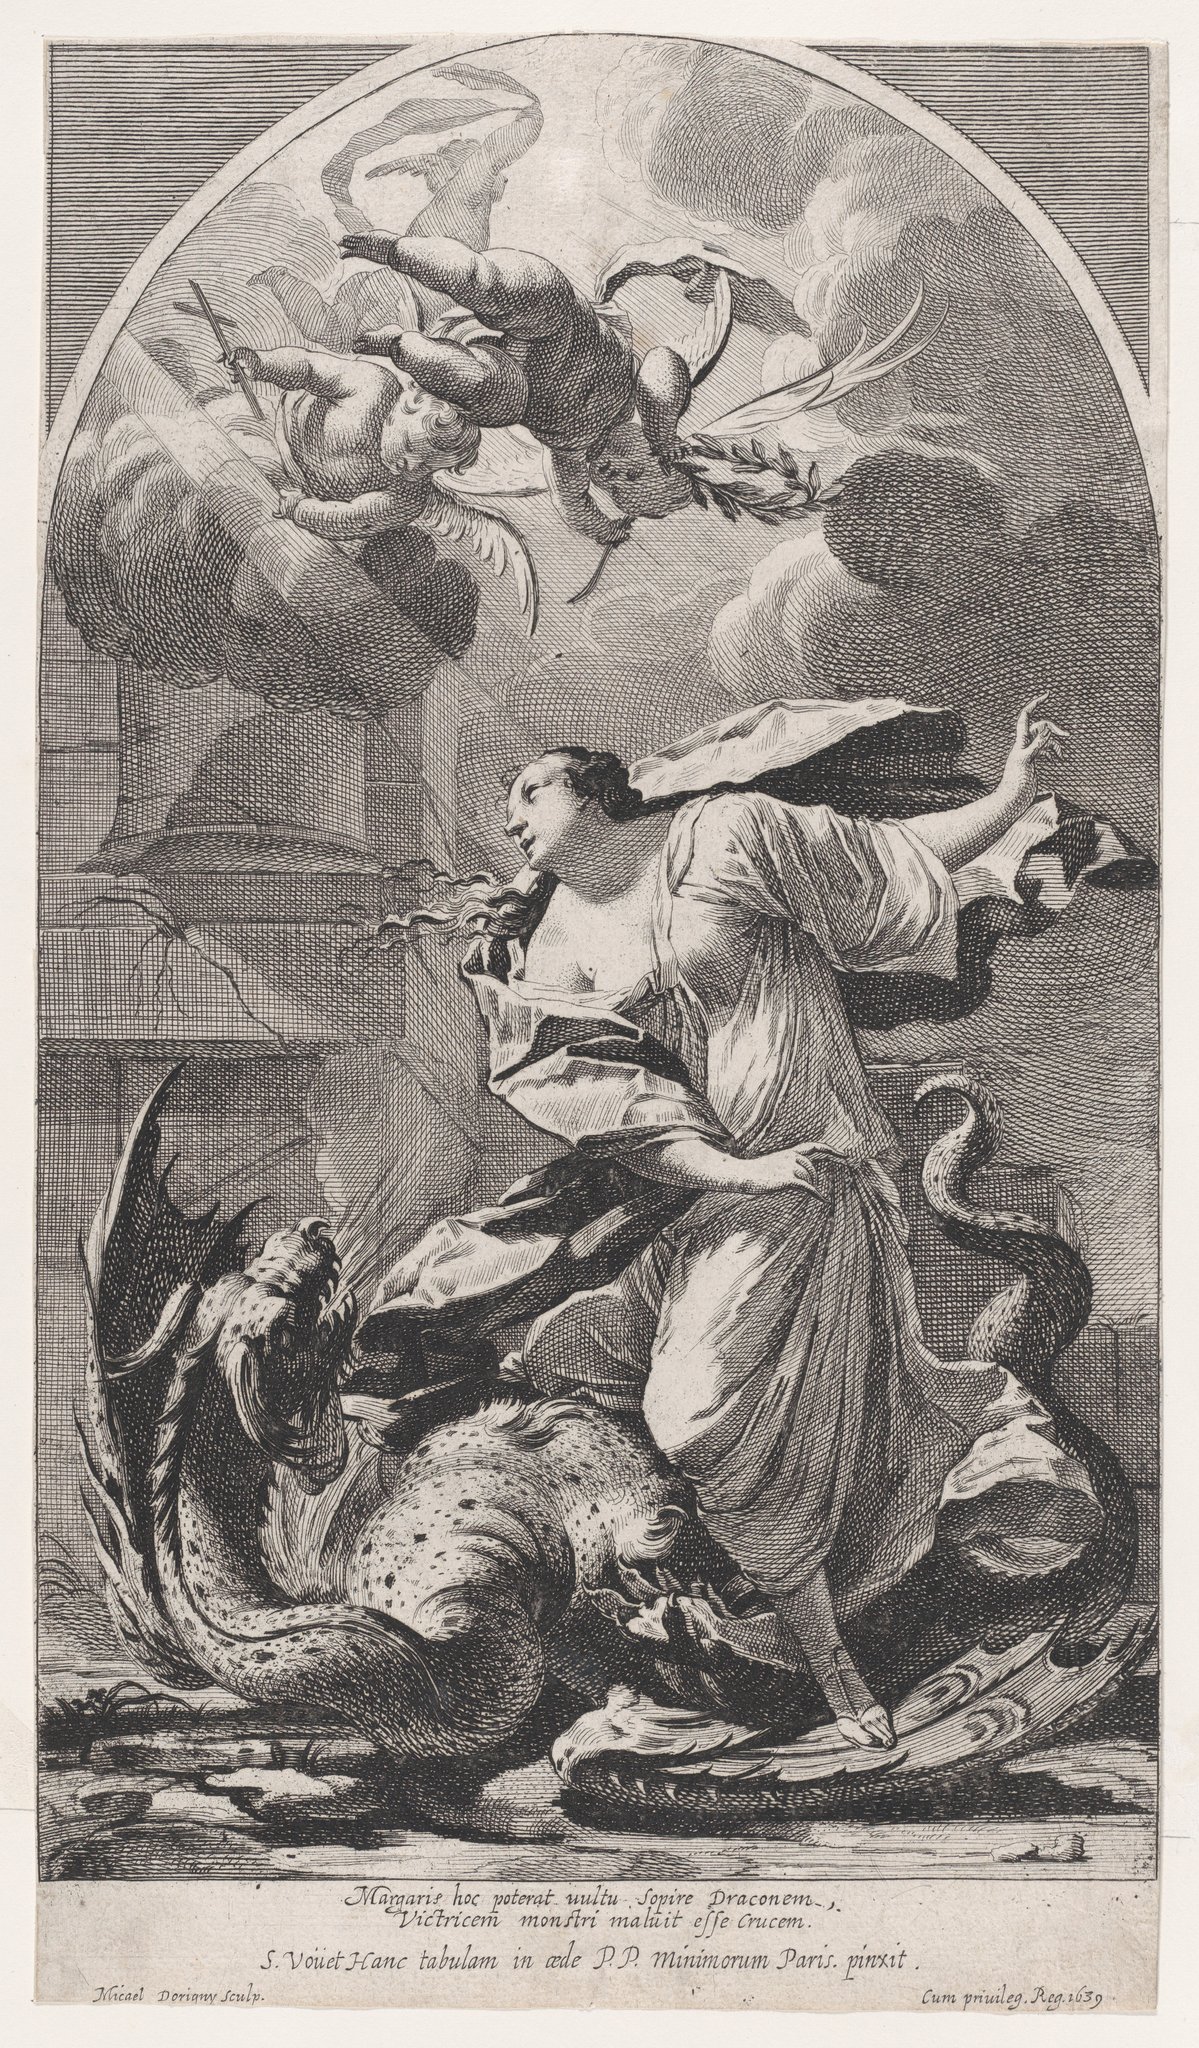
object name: print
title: Saint Margaret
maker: michel dorigny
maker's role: artist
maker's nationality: french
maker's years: 1616-1665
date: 1639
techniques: etching